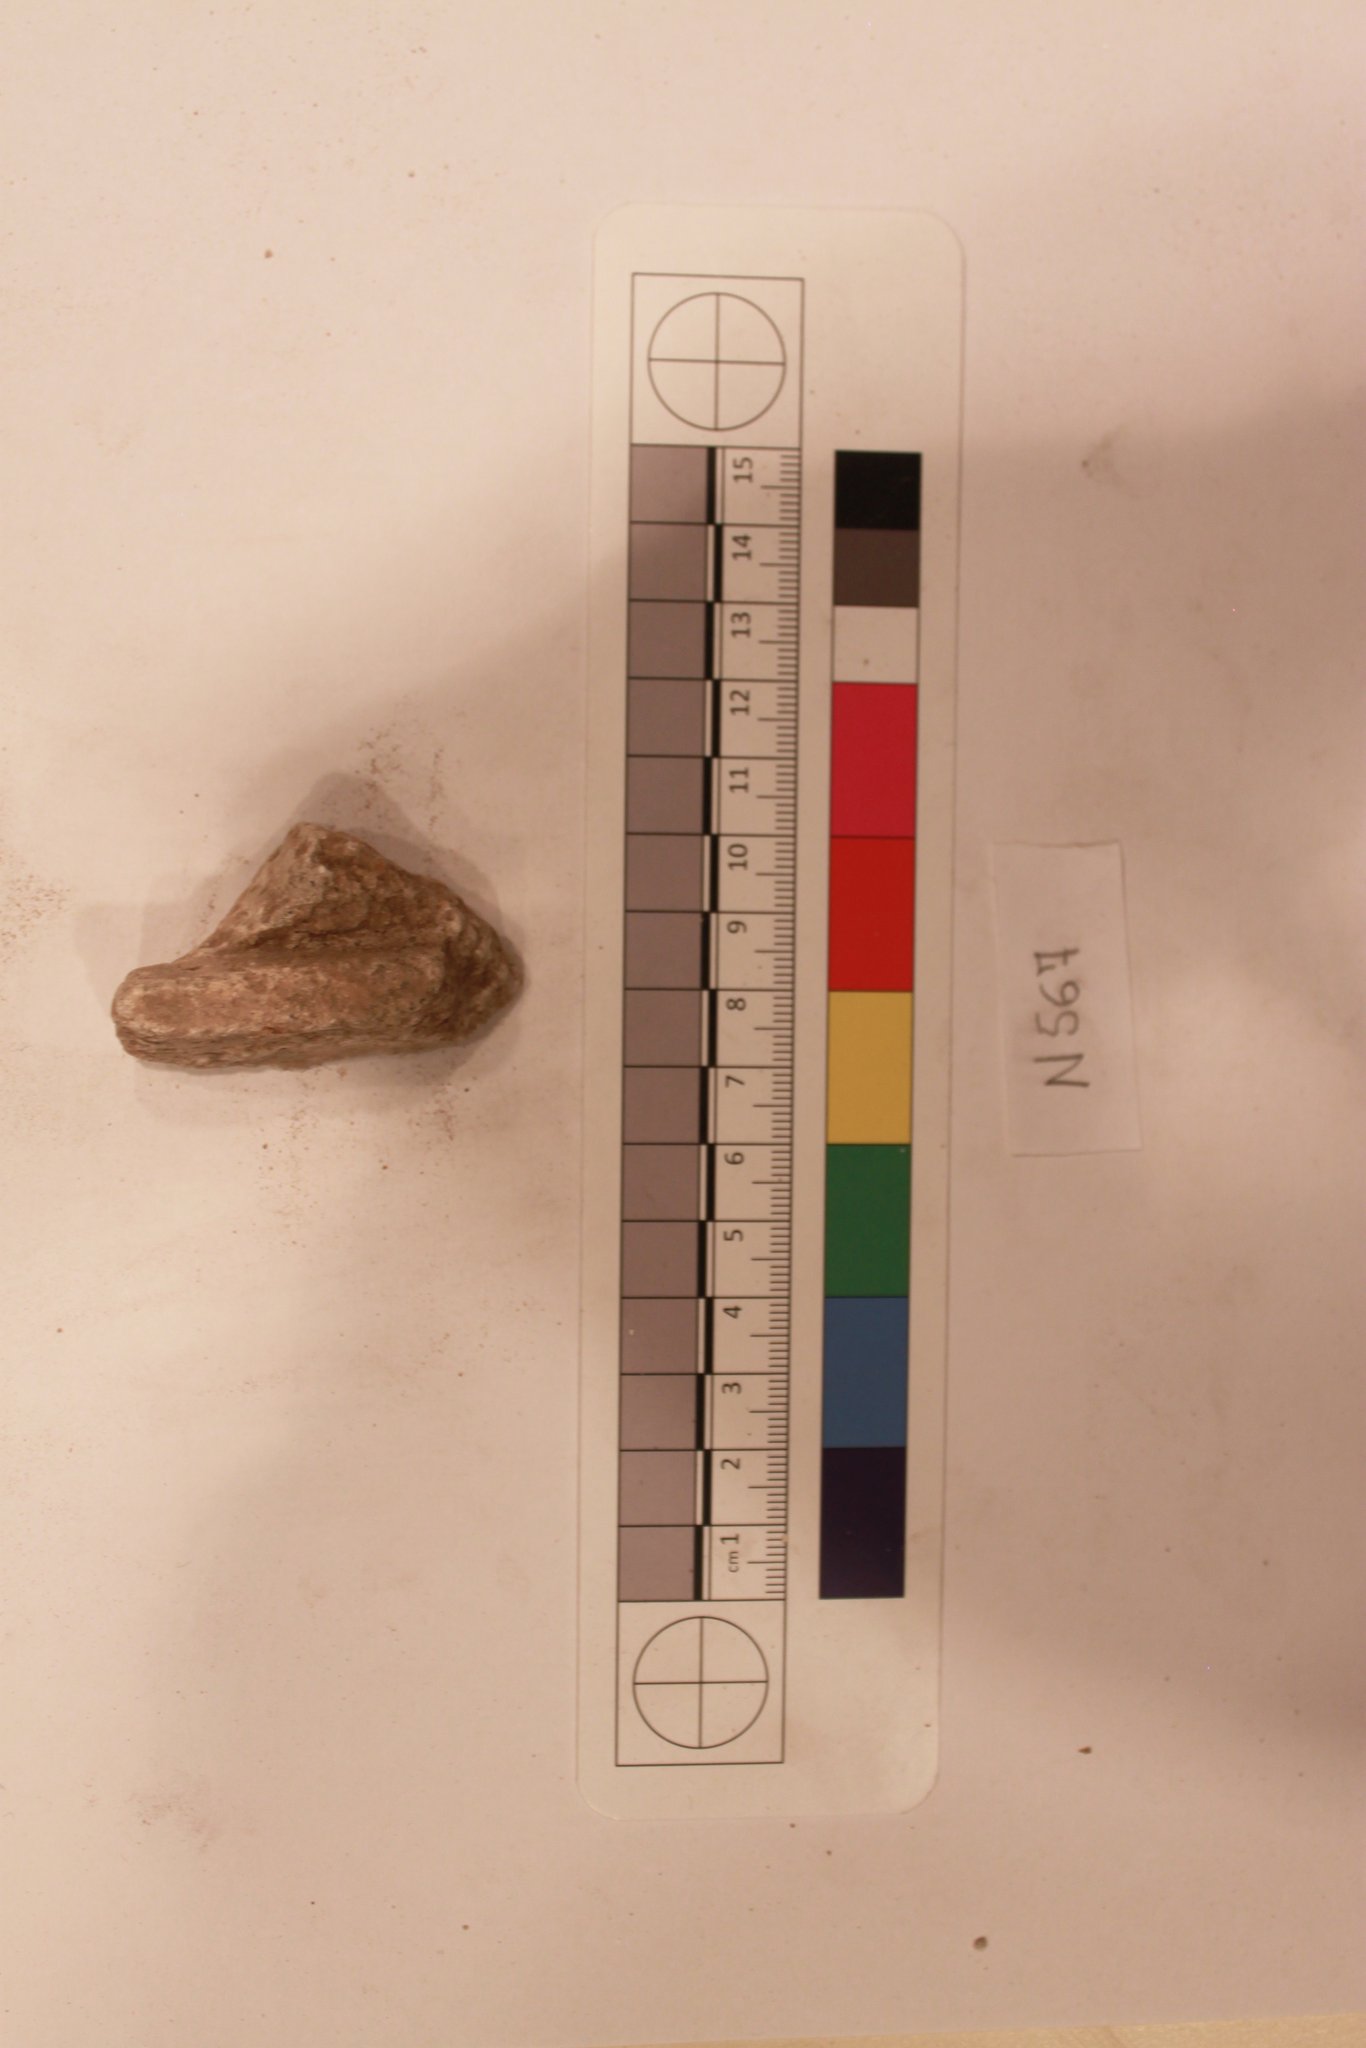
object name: fragment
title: Stucco Fragment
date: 701-1200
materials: plaster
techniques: carving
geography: iran